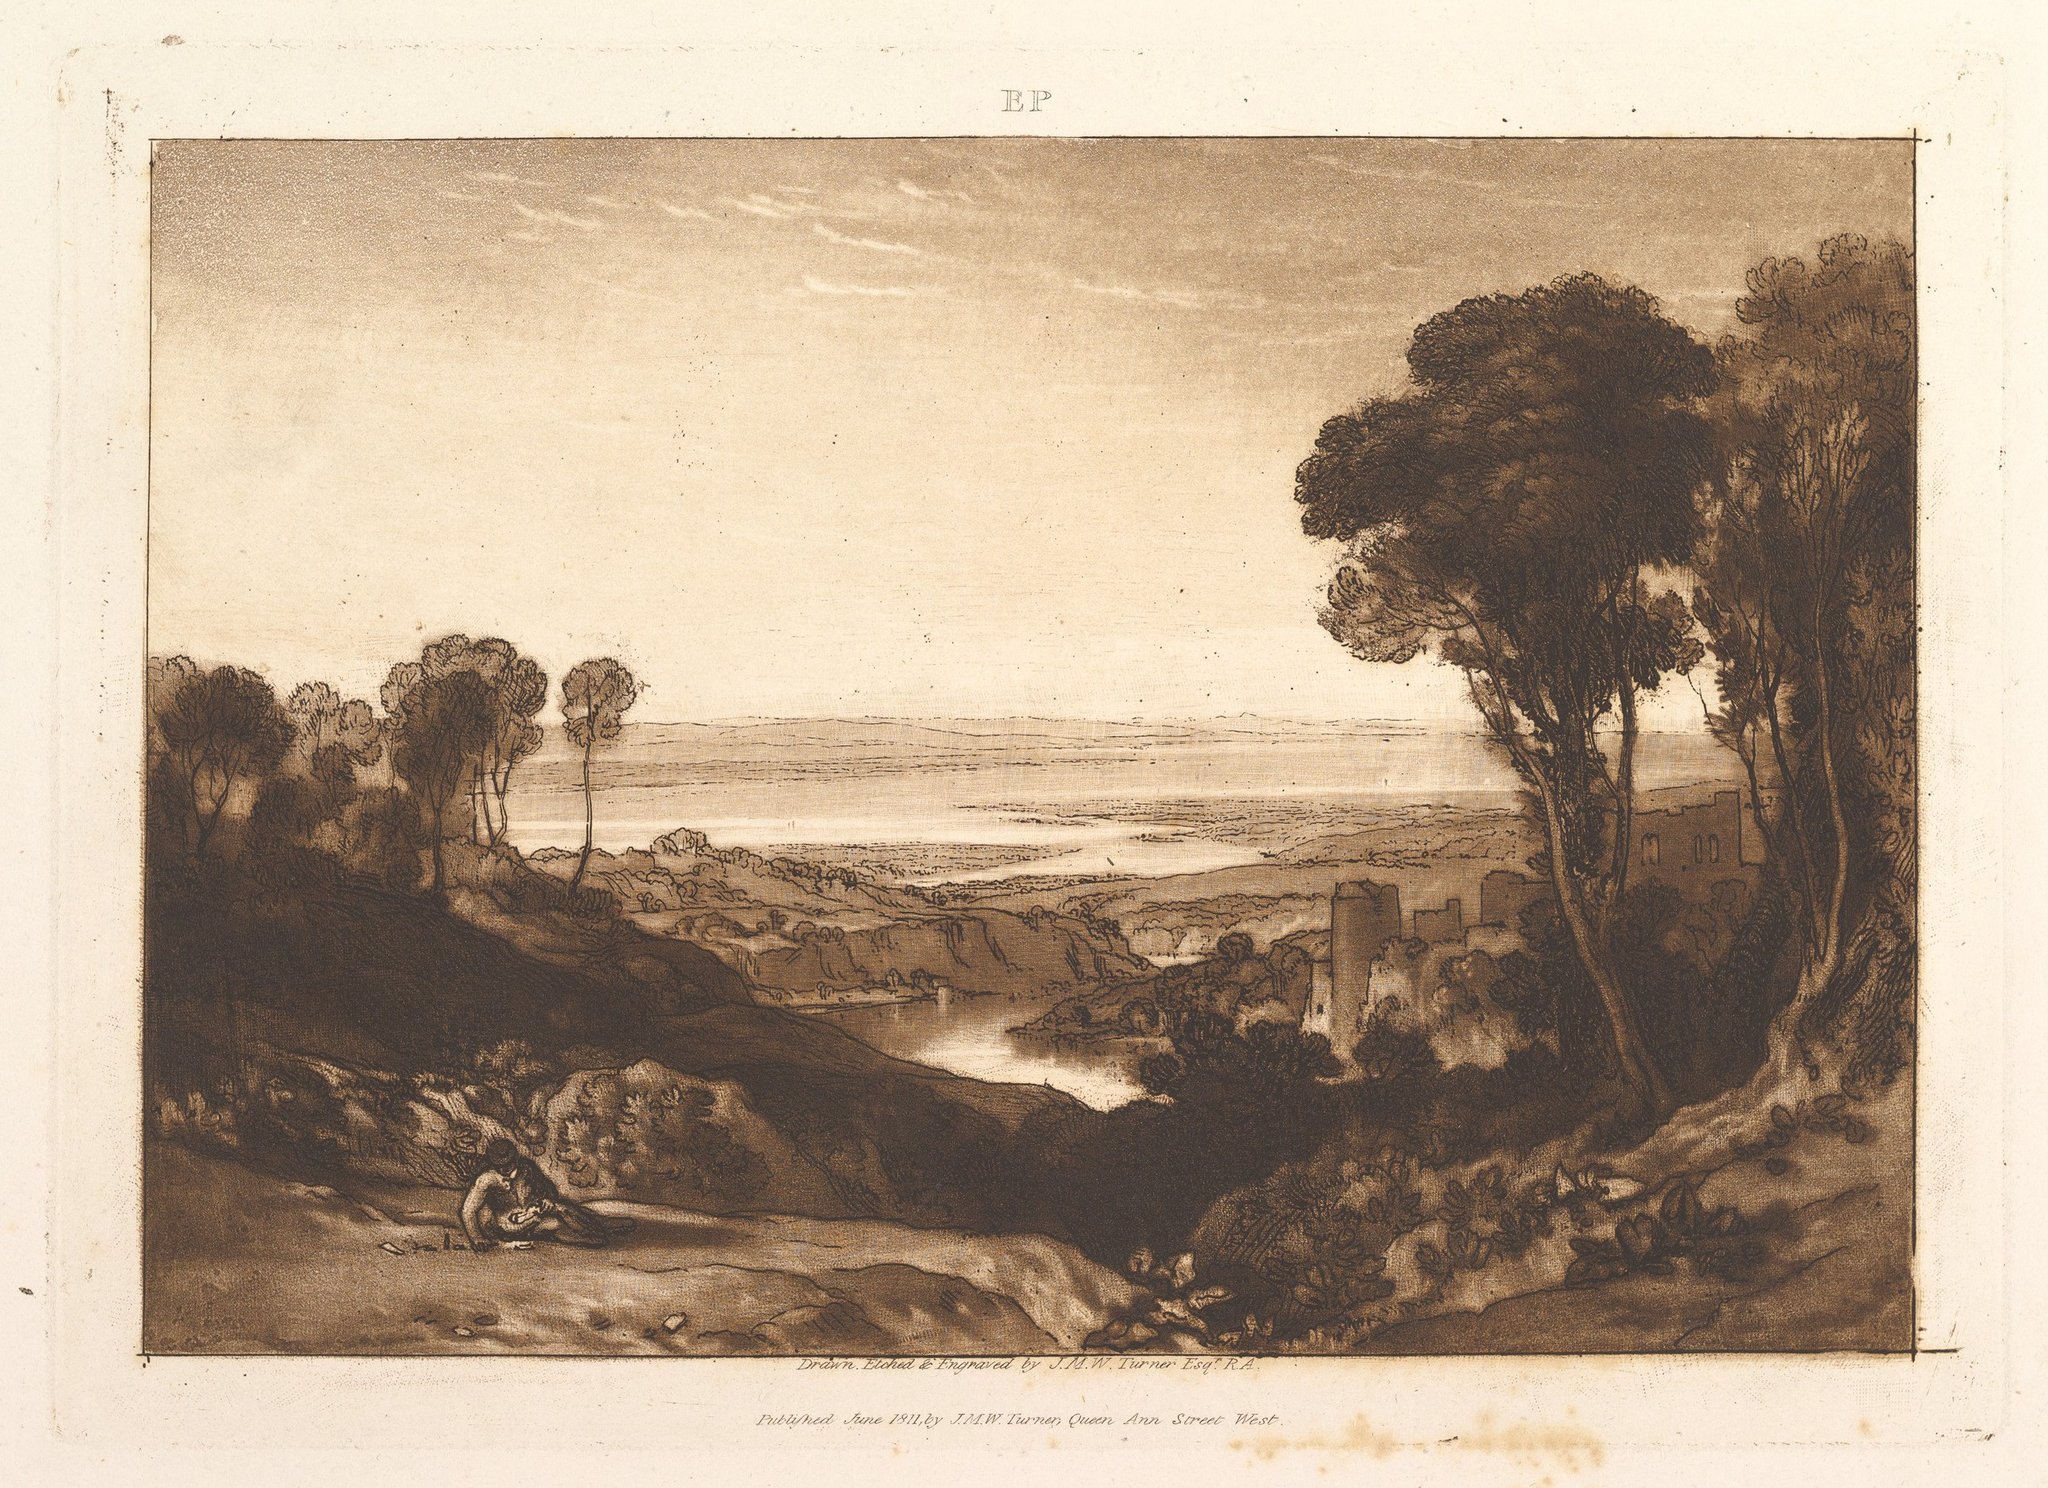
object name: print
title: Junction of Severn and Wye, part VI, plate 28 from "Liber Studiorum"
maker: joseph mallord william turner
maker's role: artist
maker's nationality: british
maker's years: 1775-1851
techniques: aquatint, etching, mezzotint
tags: landscapes